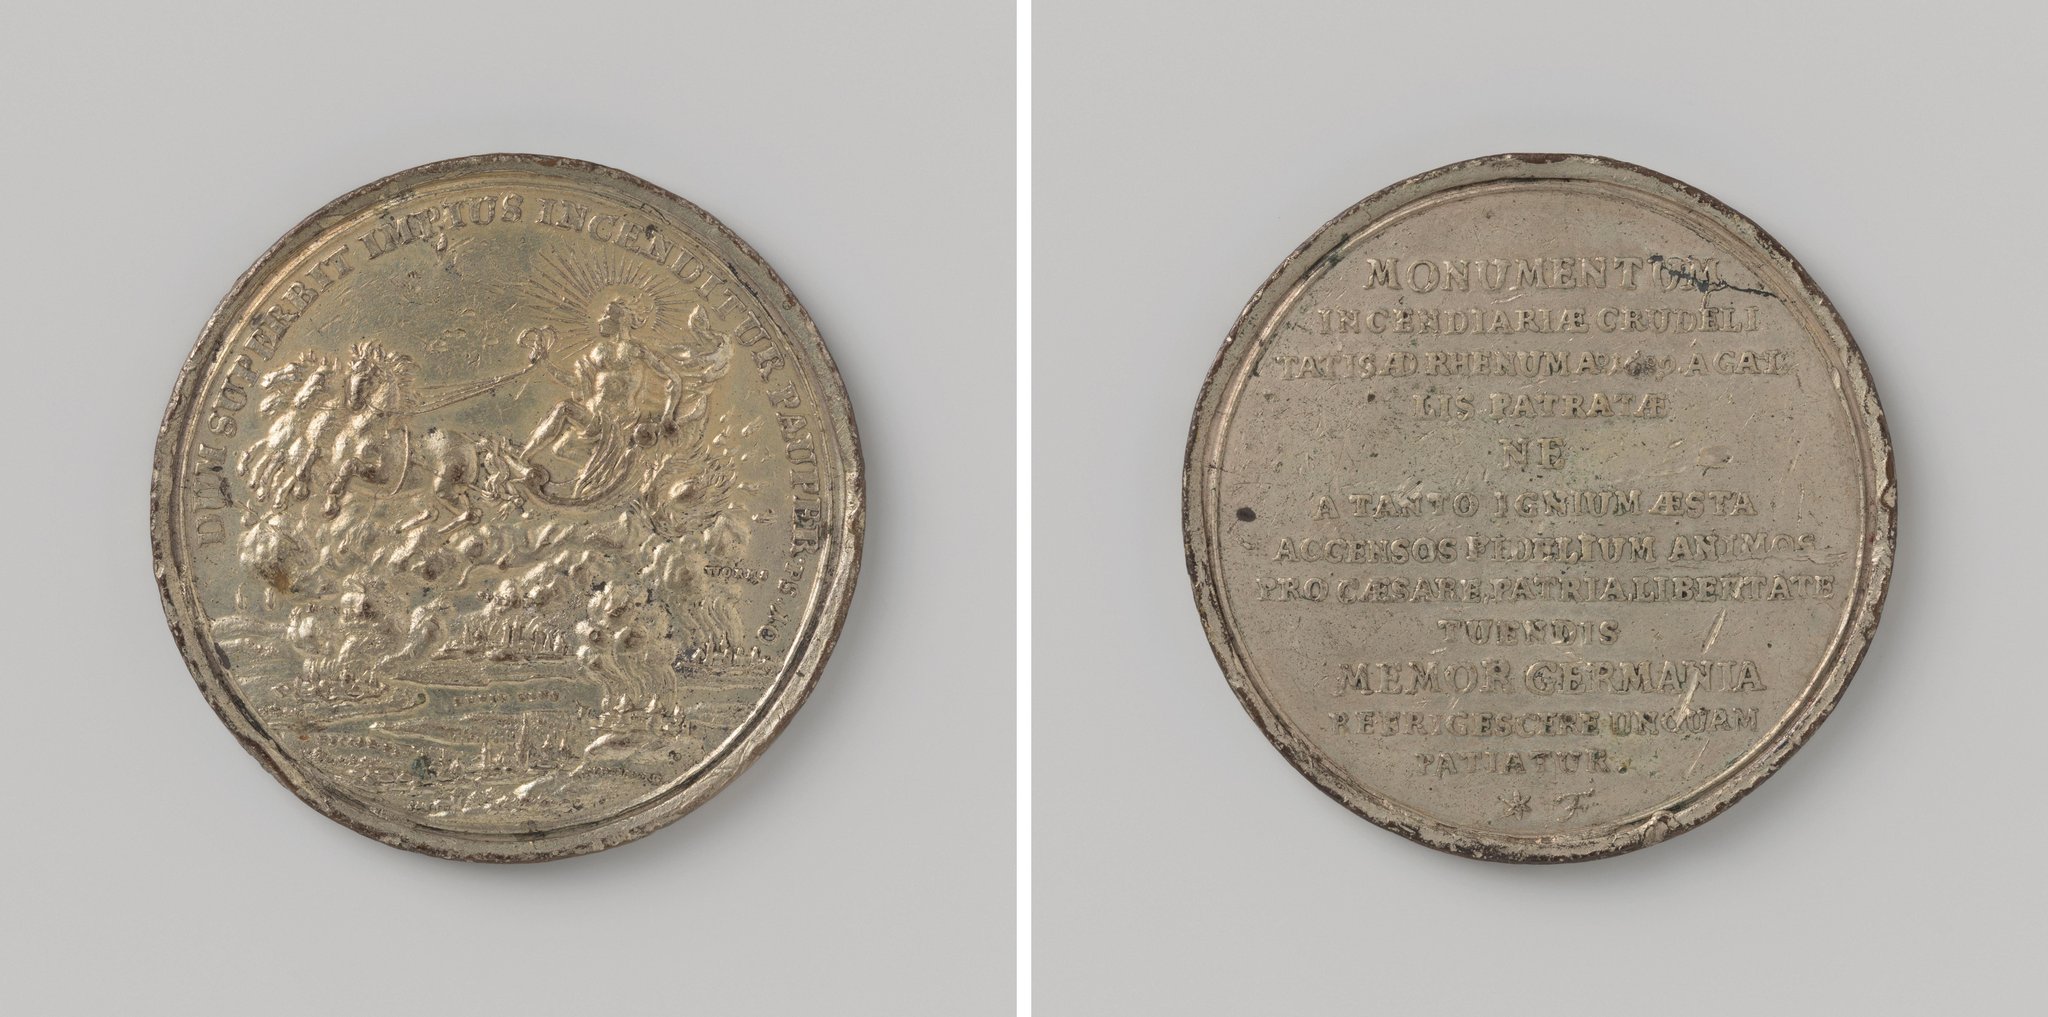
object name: copy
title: Heidelberg, Mannheim, Speyer en Worms door de Fransen verwoest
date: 1689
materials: silver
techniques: striking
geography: nuremberg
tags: speyer, heidelberg, mannheim, worms, negenjarige oorlog